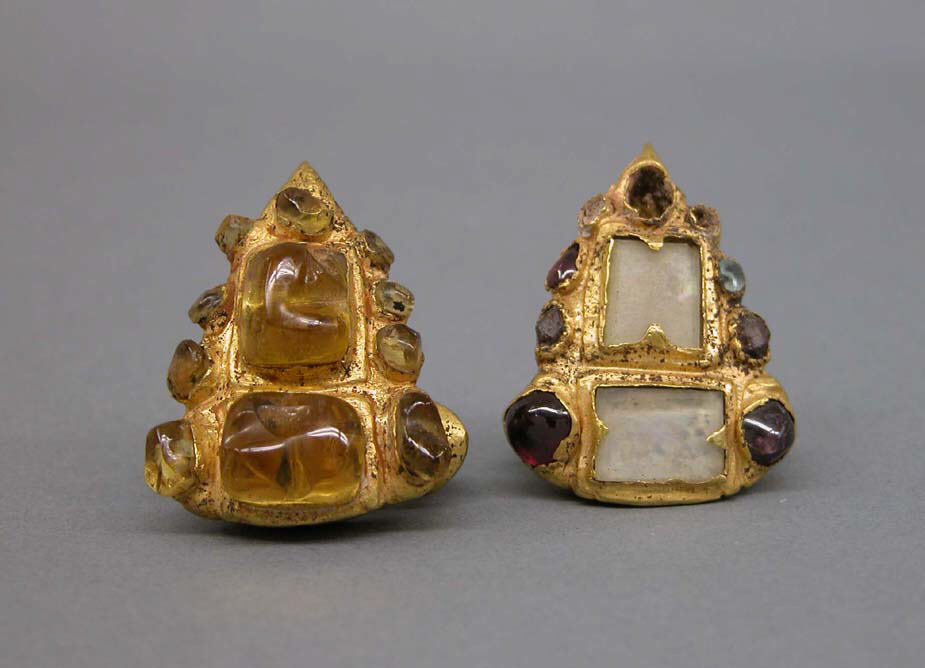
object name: ear ornament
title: Pair of Ear Ornaments Inlaid with Stones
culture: indonesian, javanese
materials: gold, stone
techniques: inlay